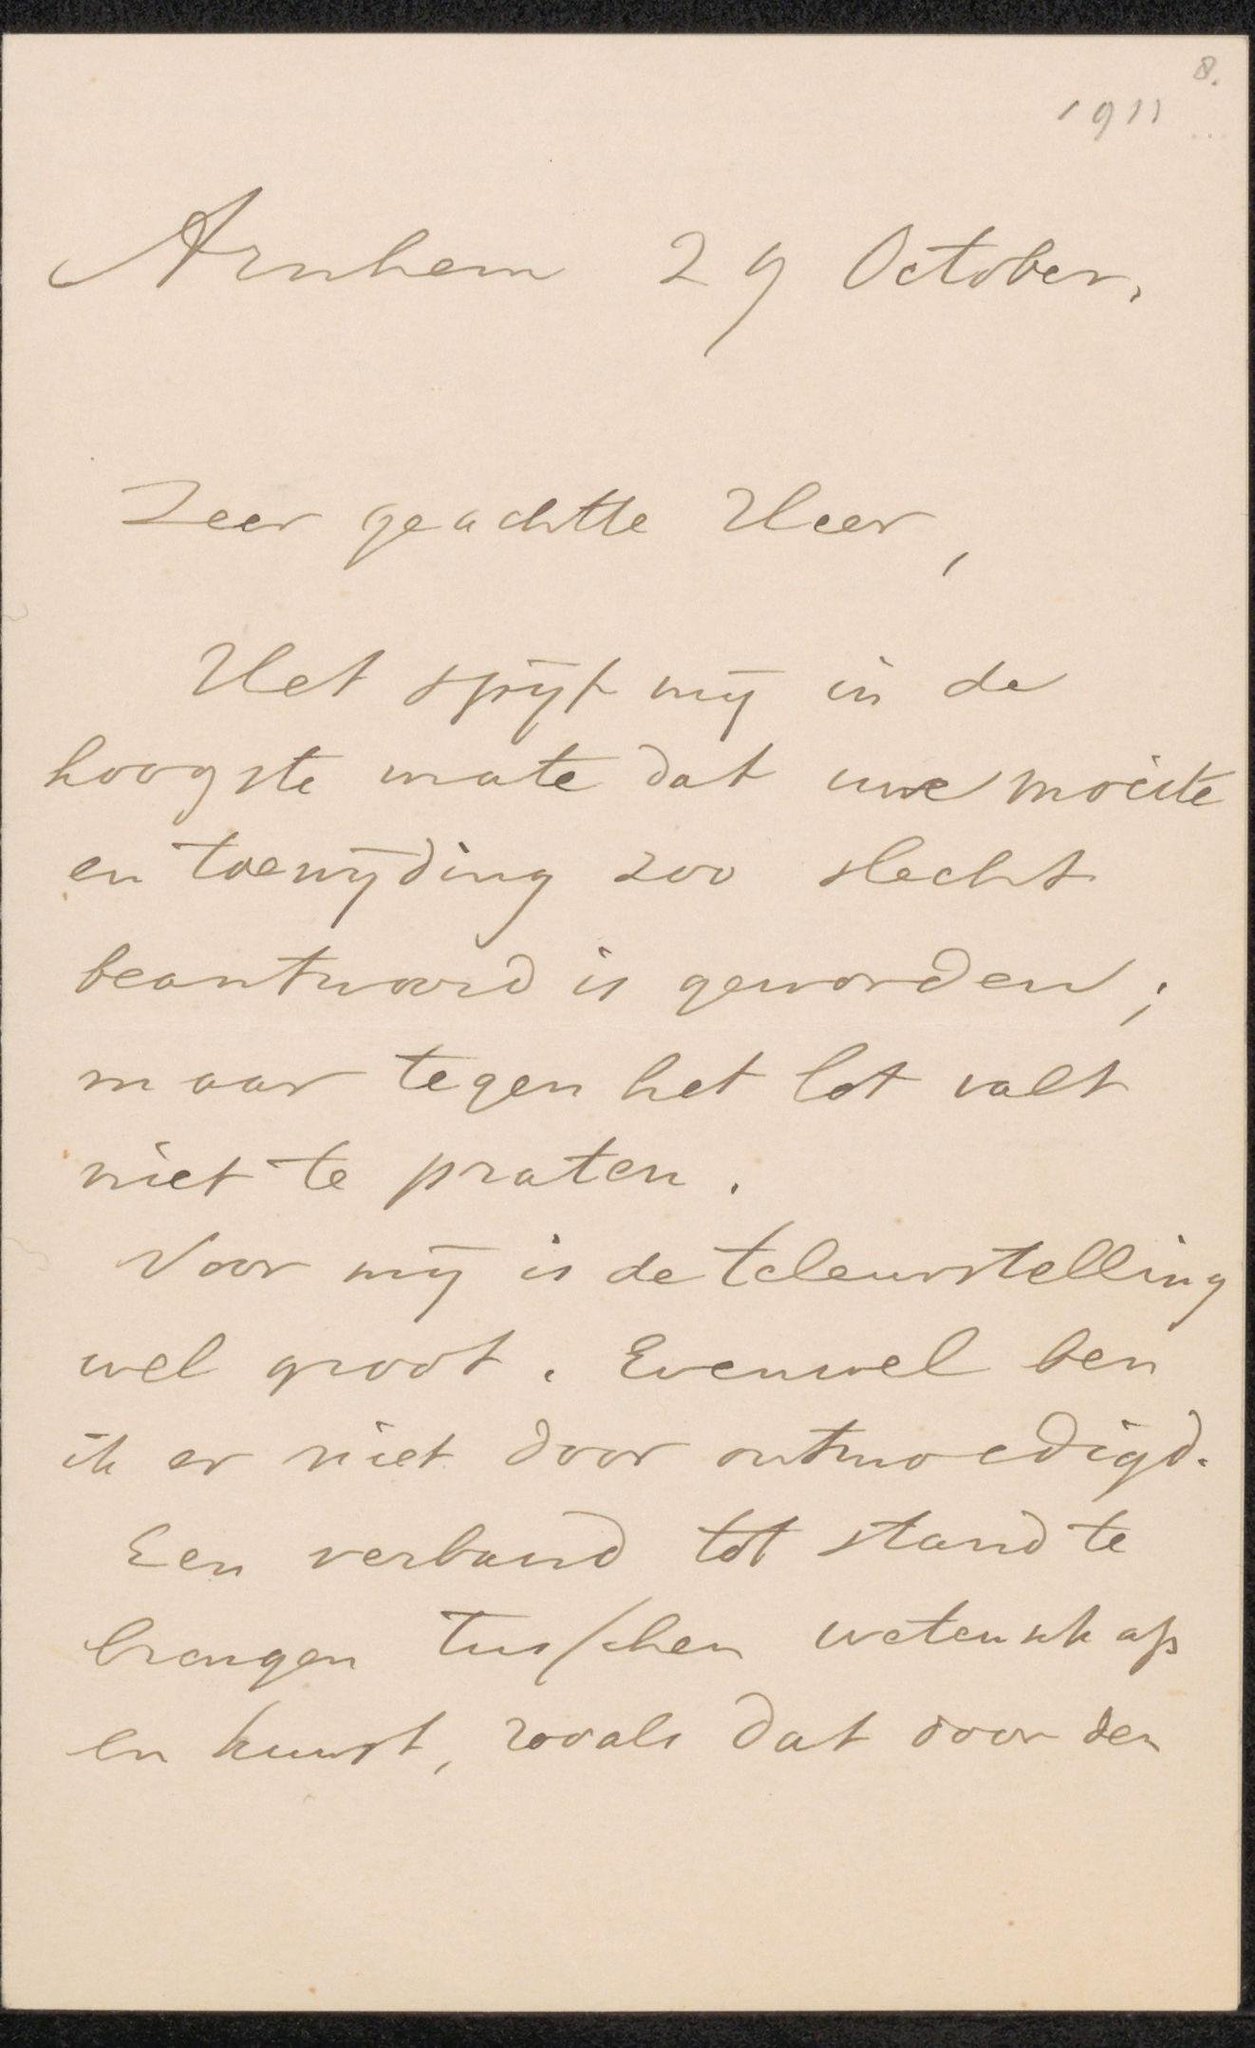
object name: letter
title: Brief aan Pieter Haverkorn van Rijsewijk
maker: theo colenbrander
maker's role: draughtsman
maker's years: 1841-1930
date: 1851-1915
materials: ink, paper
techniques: pen, writing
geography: arnhem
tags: pieter haverkorn van rijsewijk, passions, emotions, affections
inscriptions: collector's mark: ‘RPK’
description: Brief gedateerd 29 October door schrijver, met toevoeging 1911 in latere hand.